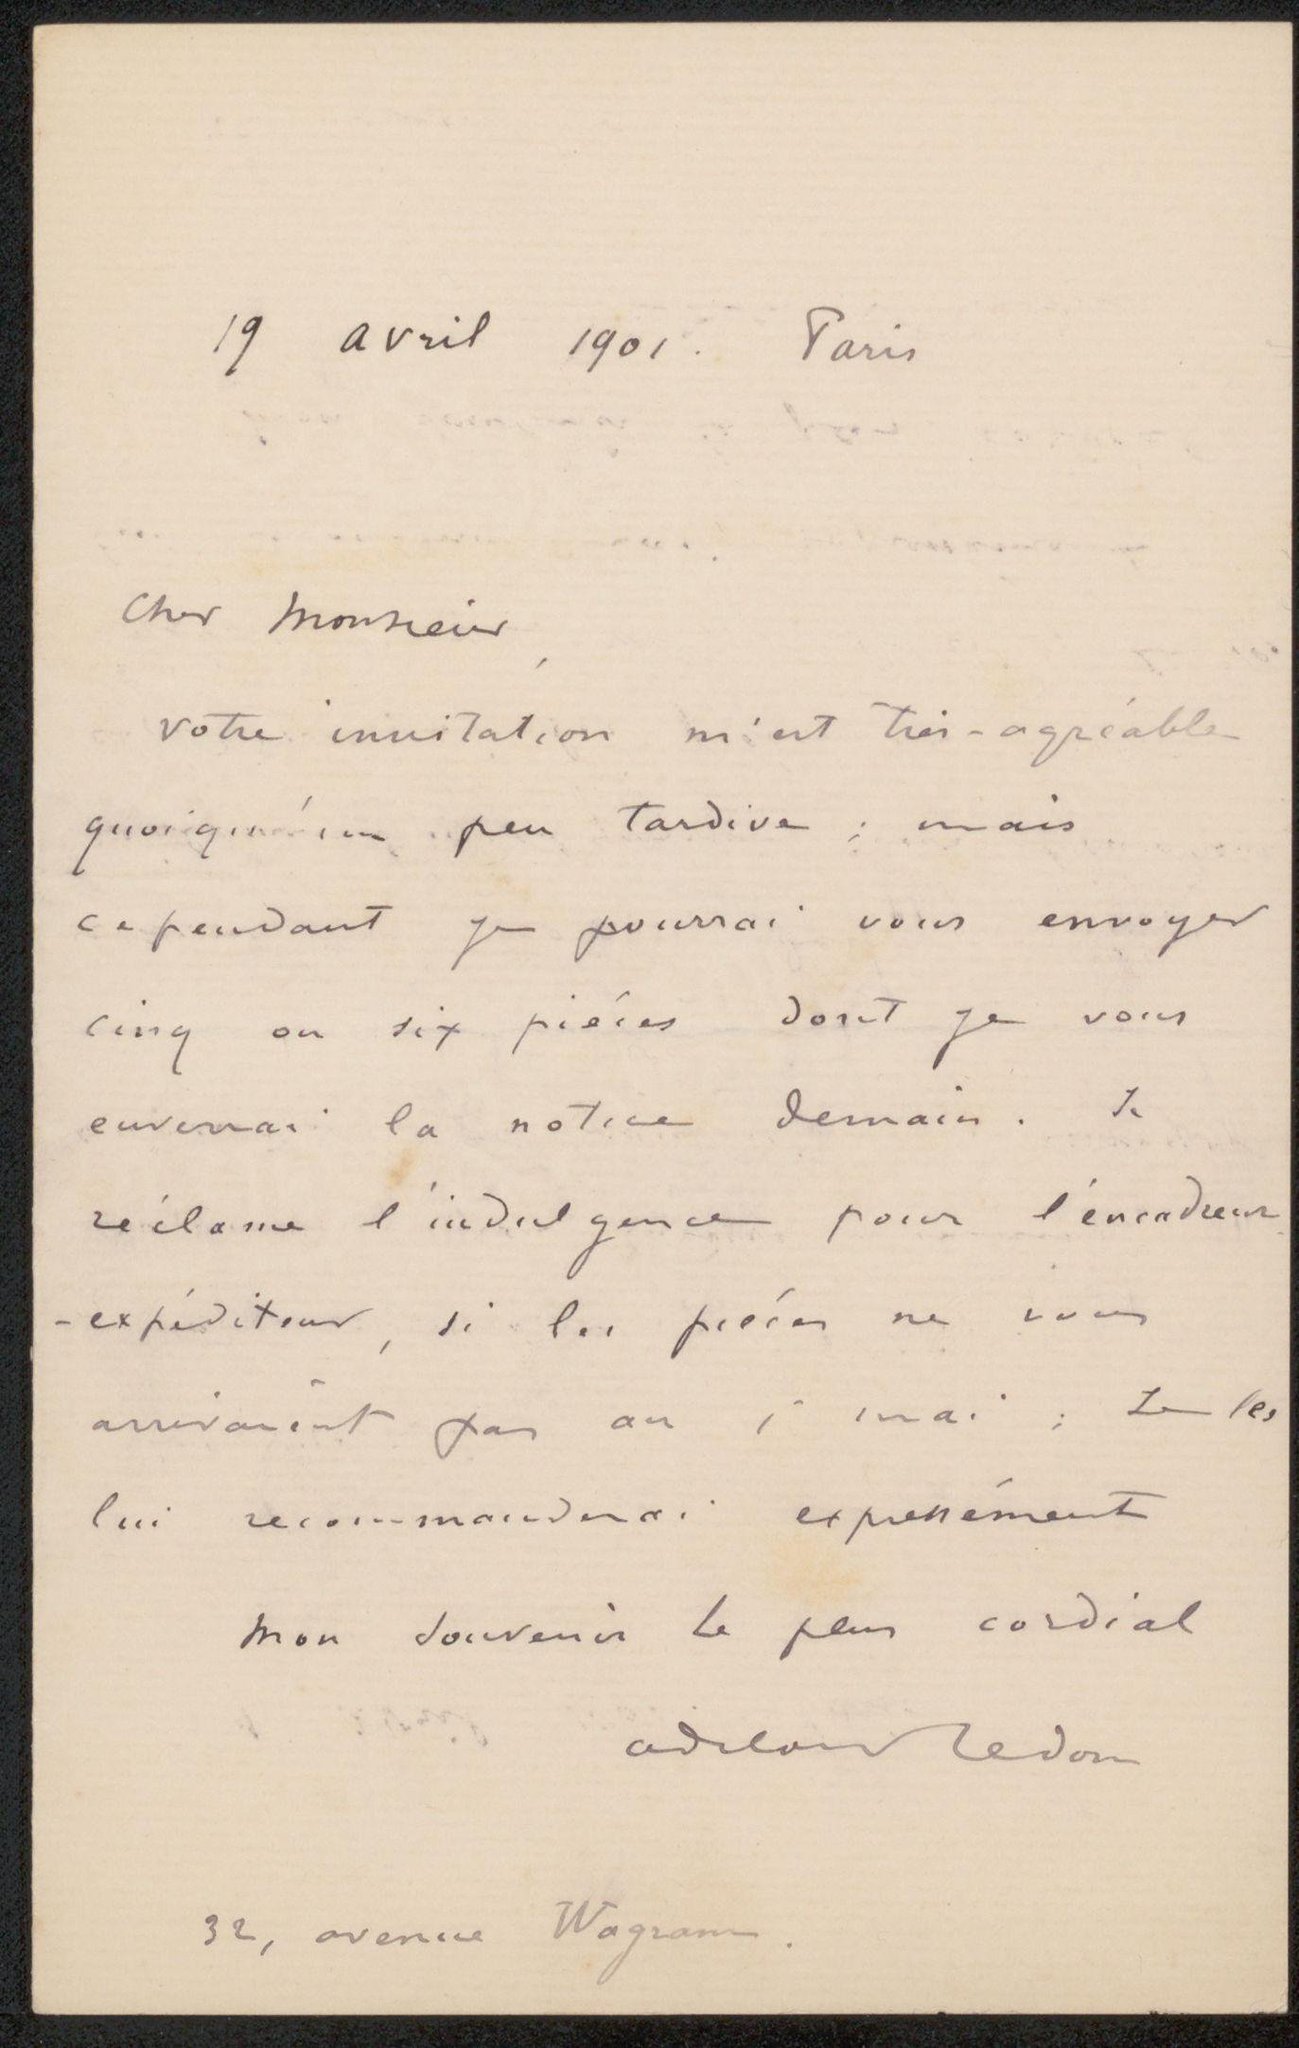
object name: letter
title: Brief aan Philip Zilcken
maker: odilon redon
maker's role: draughtsman, painter, print maker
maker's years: 1840-1916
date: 1901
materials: ink, paper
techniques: pen, writing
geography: paris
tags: painter, draughtsman, philip zilcken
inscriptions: watermark, collector's mark: ‘RPK’